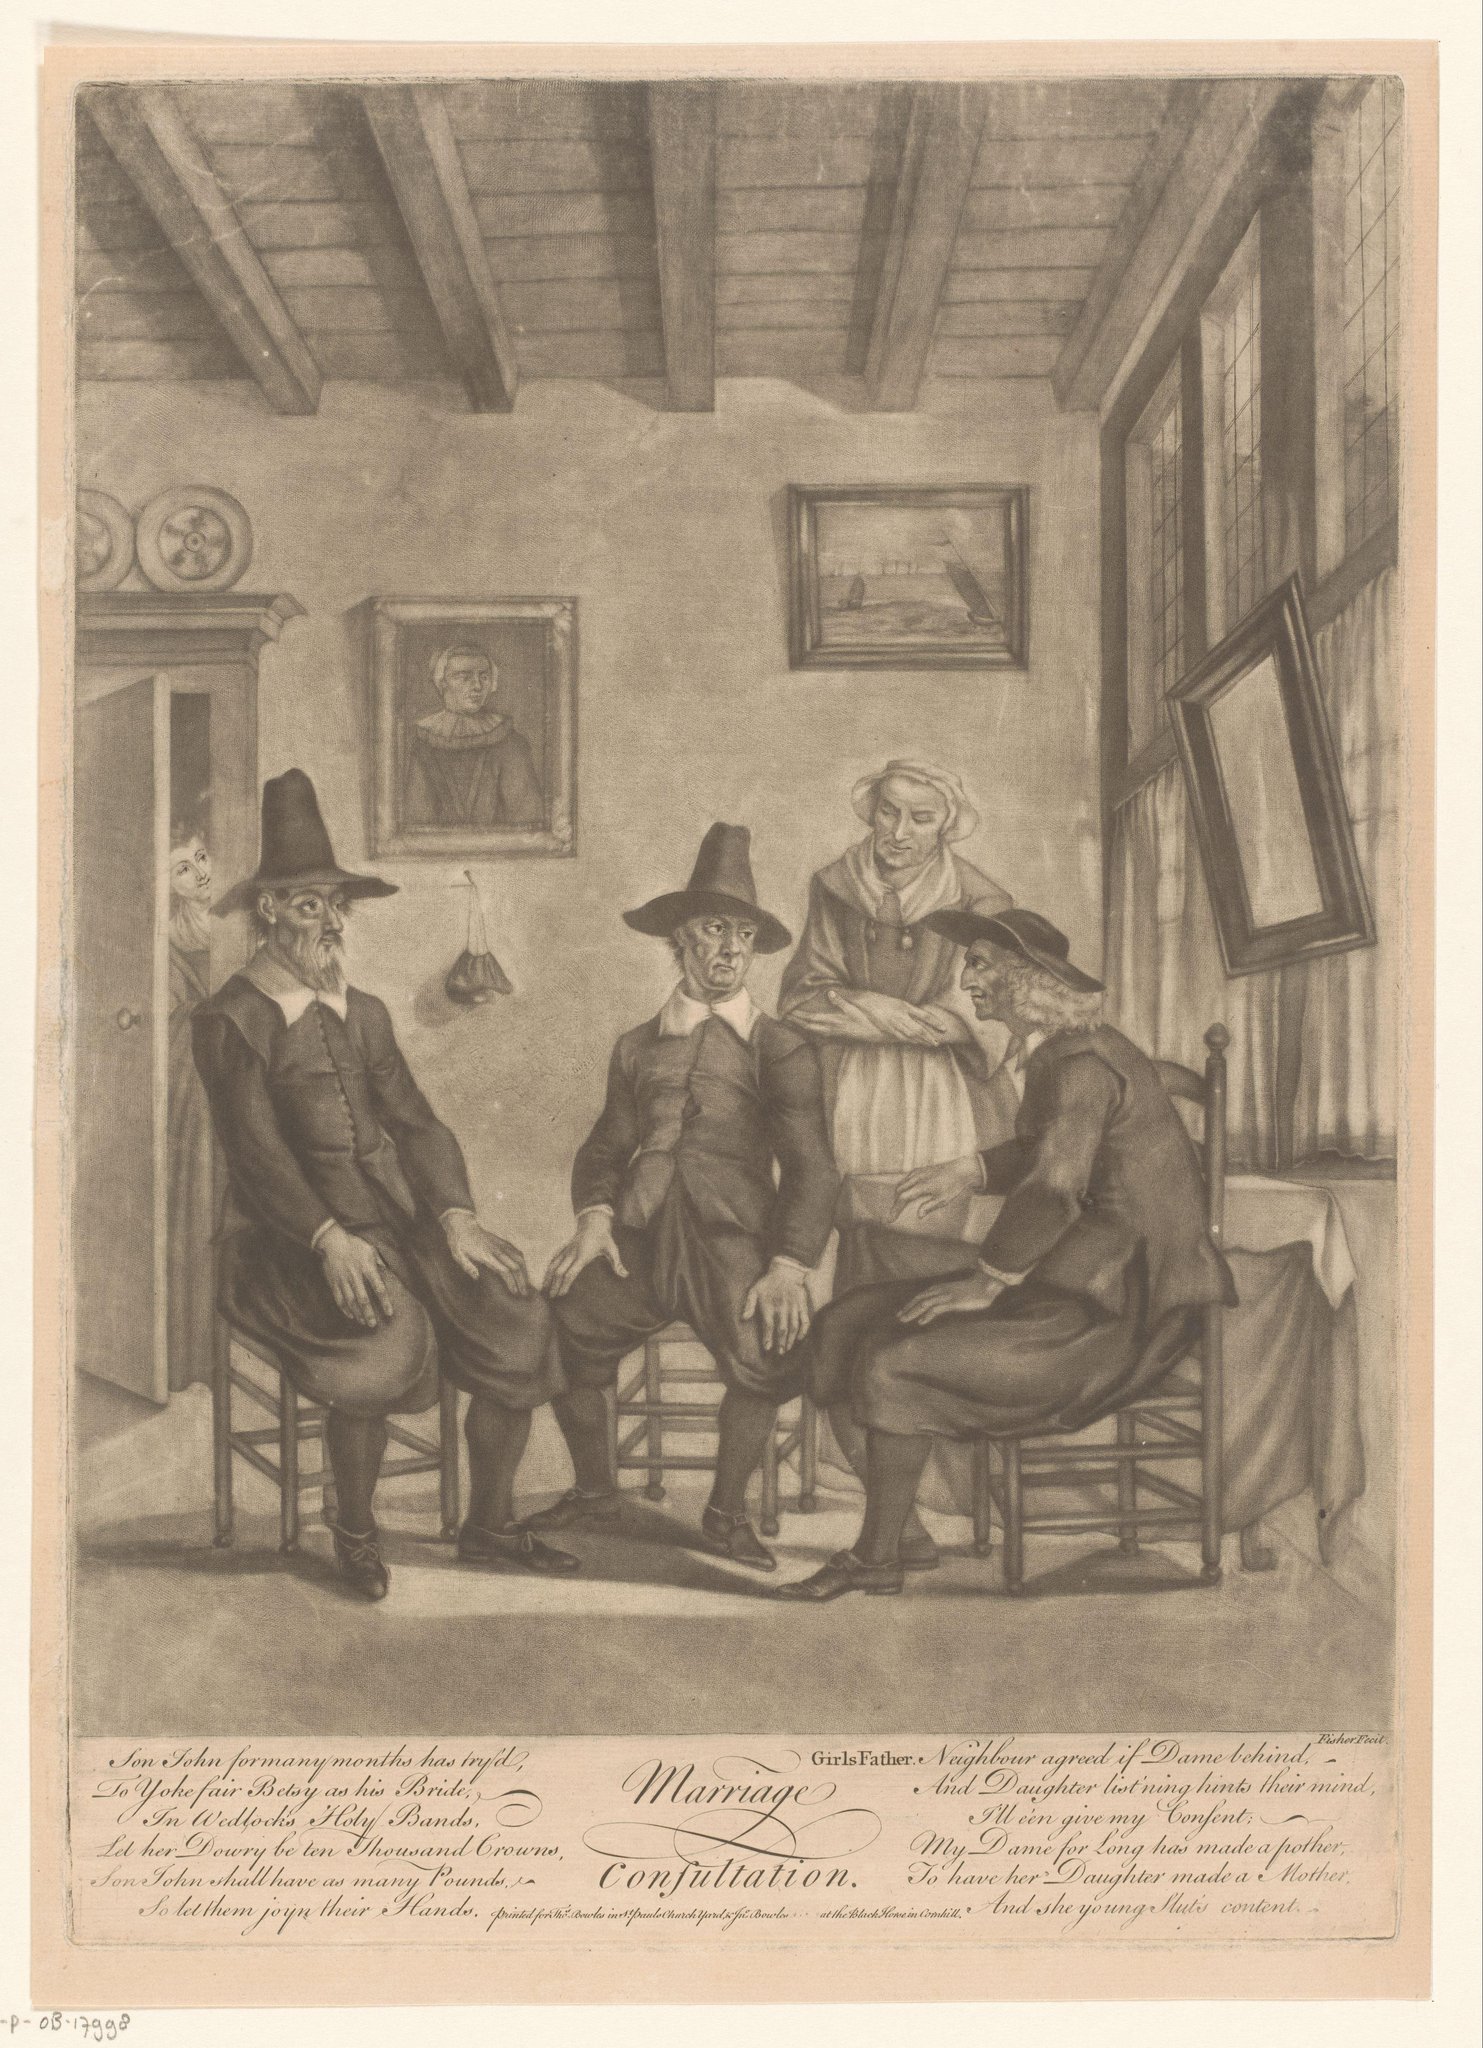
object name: print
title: Interieur met vier personen pratend over een huwelijk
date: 1738-1766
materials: paper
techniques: etching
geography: london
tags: parental agreement ~ marriage, eavesdropper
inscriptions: collector's mark: Lugt 2228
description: Prent is naar een schilderij van Cornelis Troost. Het schilderij is een illustratie bij de klucht 'Jan Claasz of de gewaande dienstmaagd', waarin Saartje Jans ten huwelijk wordt gevraagd namens Reinier Adriaansz. Zij luistert links mee. In het onderschrift van deze prent wordt naar de bruid en bruidegom verwezen als 'Betsy' en 'John'. Vermoedelijk illustreert de prent hier een ander werk.